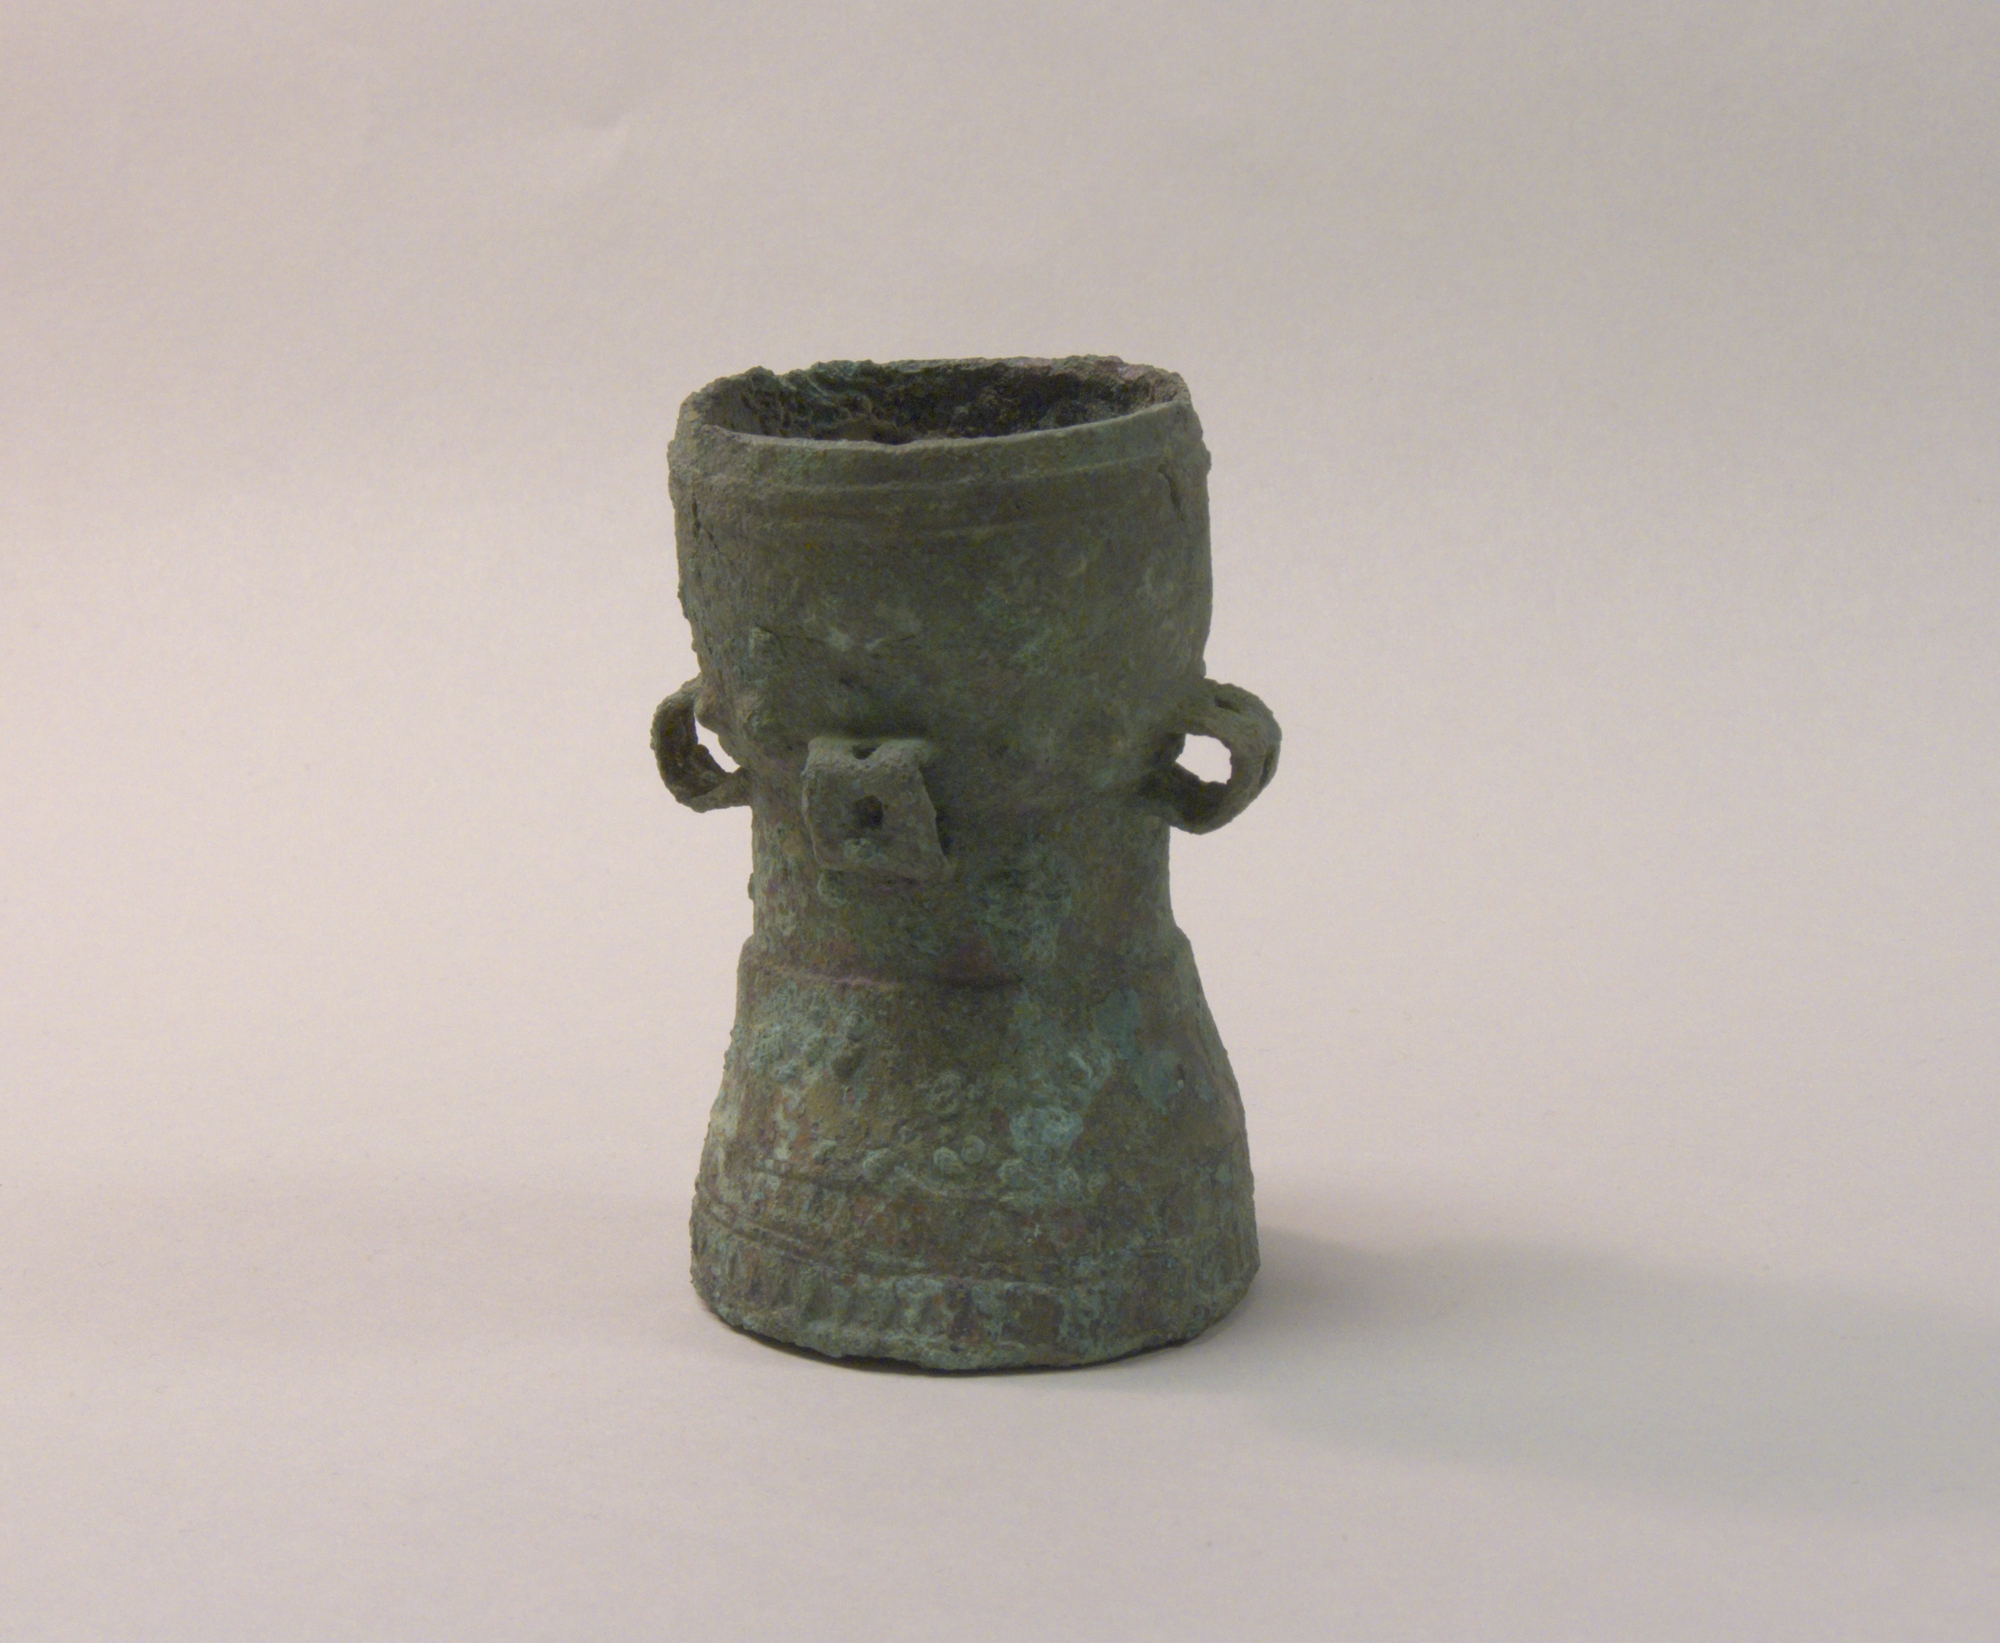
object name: lime container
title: Lime Container in the Shape of a Drum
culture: indonesian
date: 500 BCE-300 CE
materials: bronze